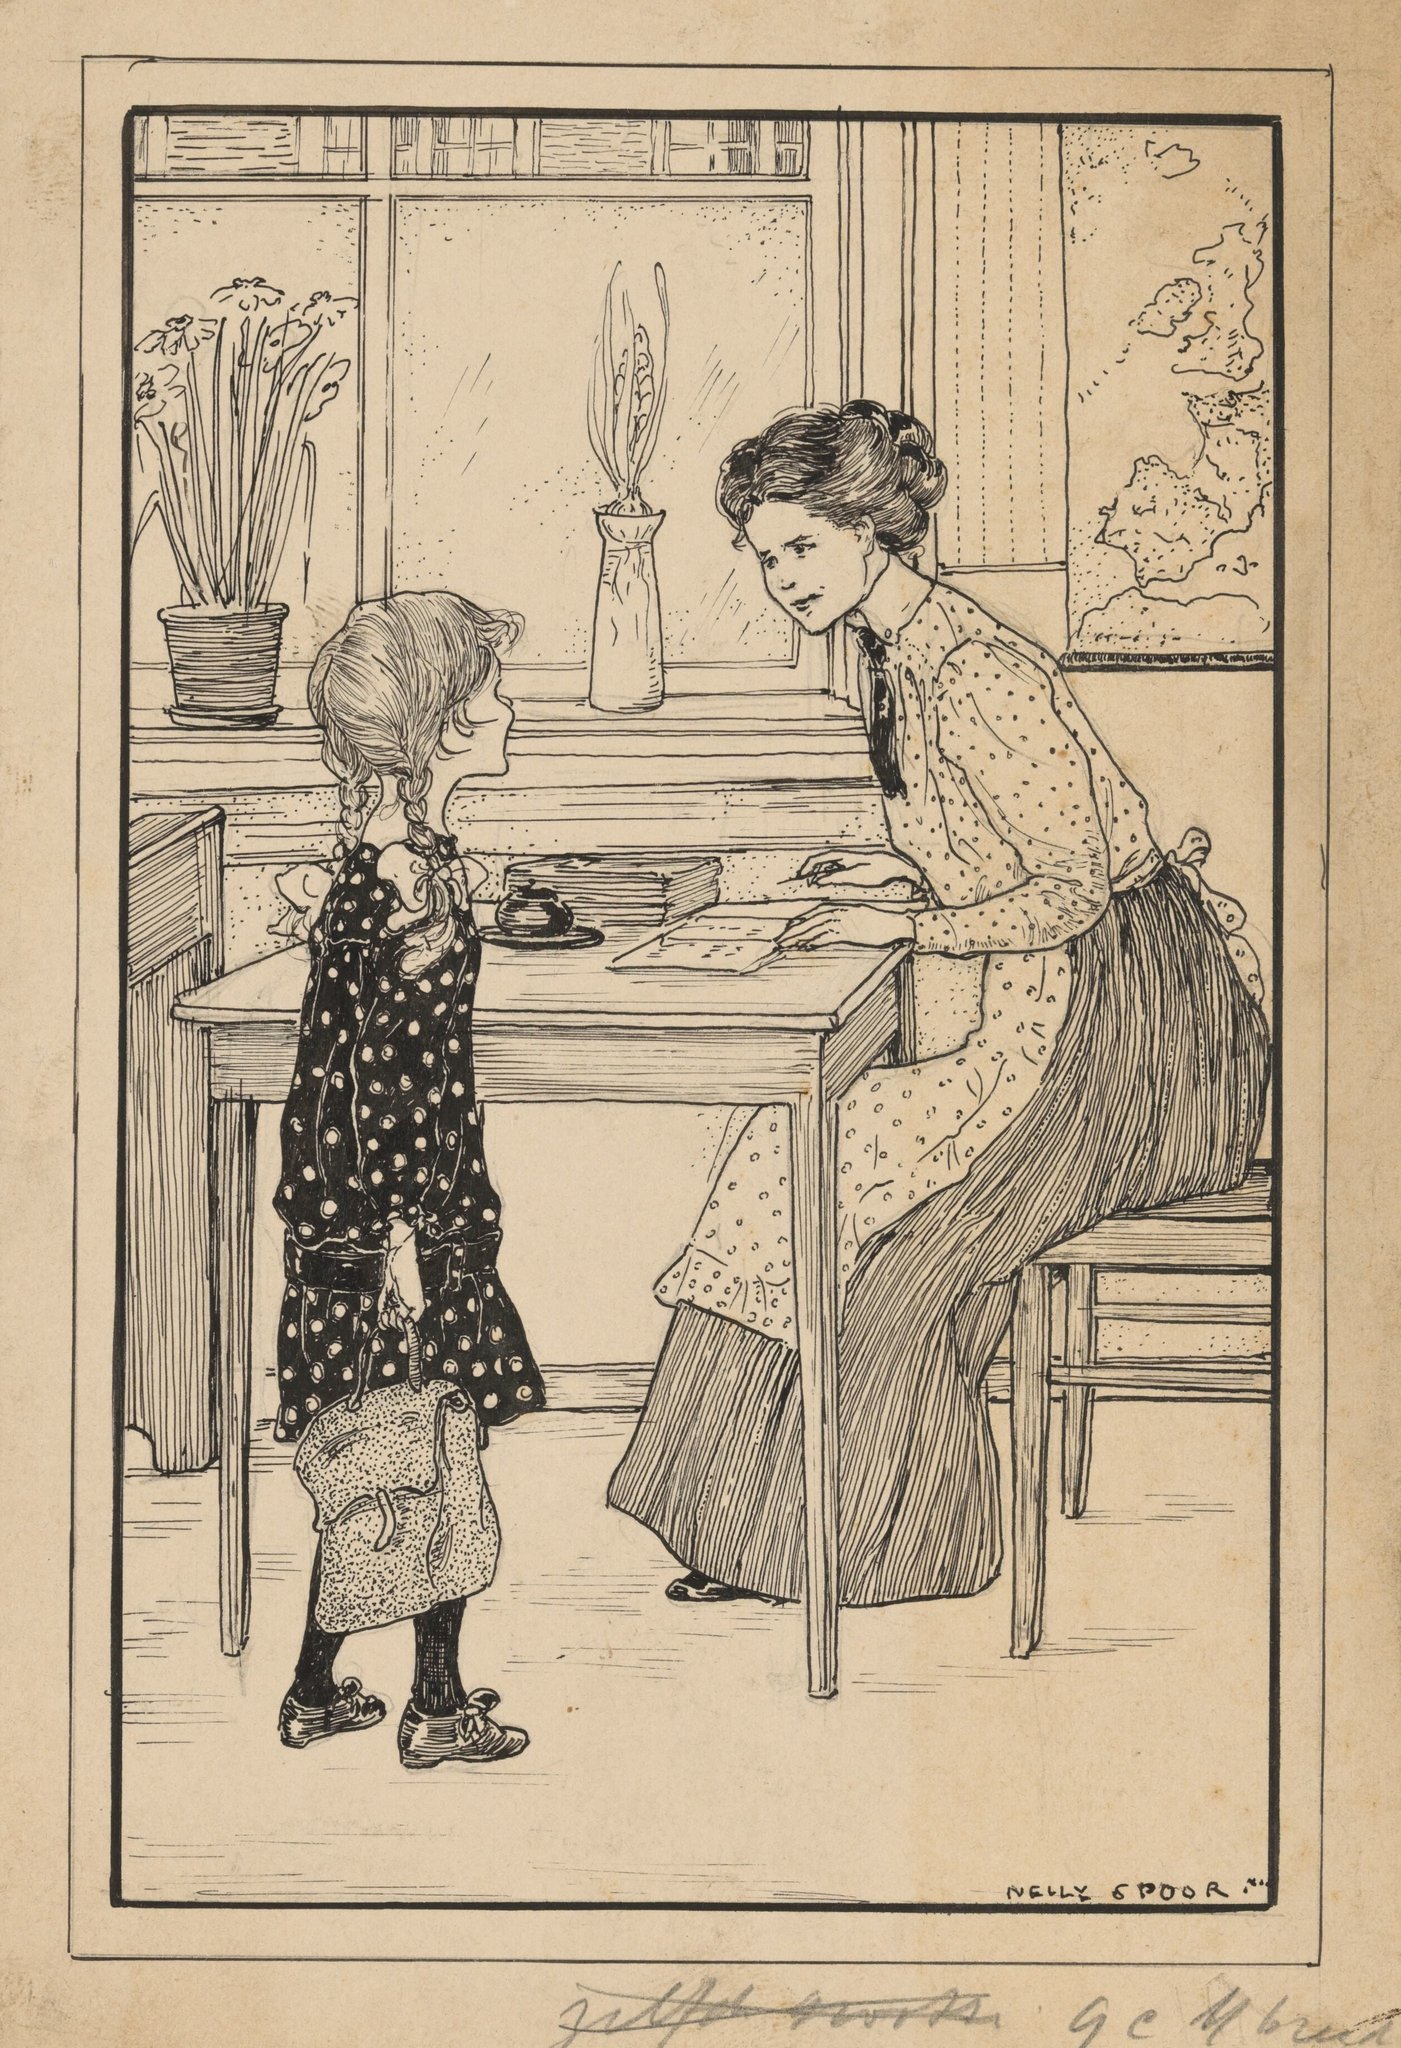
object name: drawing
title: Meisje bij het bureau van een onderwijzeres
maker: nelly spoor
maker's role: draughtsman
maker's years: 1885-1950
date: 1895-1950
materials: cardboard, ink, pencil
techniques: pen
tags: writing-table, writing-desk, teacher and pupil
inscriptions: collector's mark: Lugt 2228, signature: ‘NELLY SPOOR’, :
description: In een klaslokaal staat een meisje met een schooltas bij het bureau van een onderwijzeres. Op het bureau ligt een stapel met schriften, waarvan er één openligt voor correctie. Op de achtergrond hangt een landkaart aan de muur en staan planten in de vensterbank.